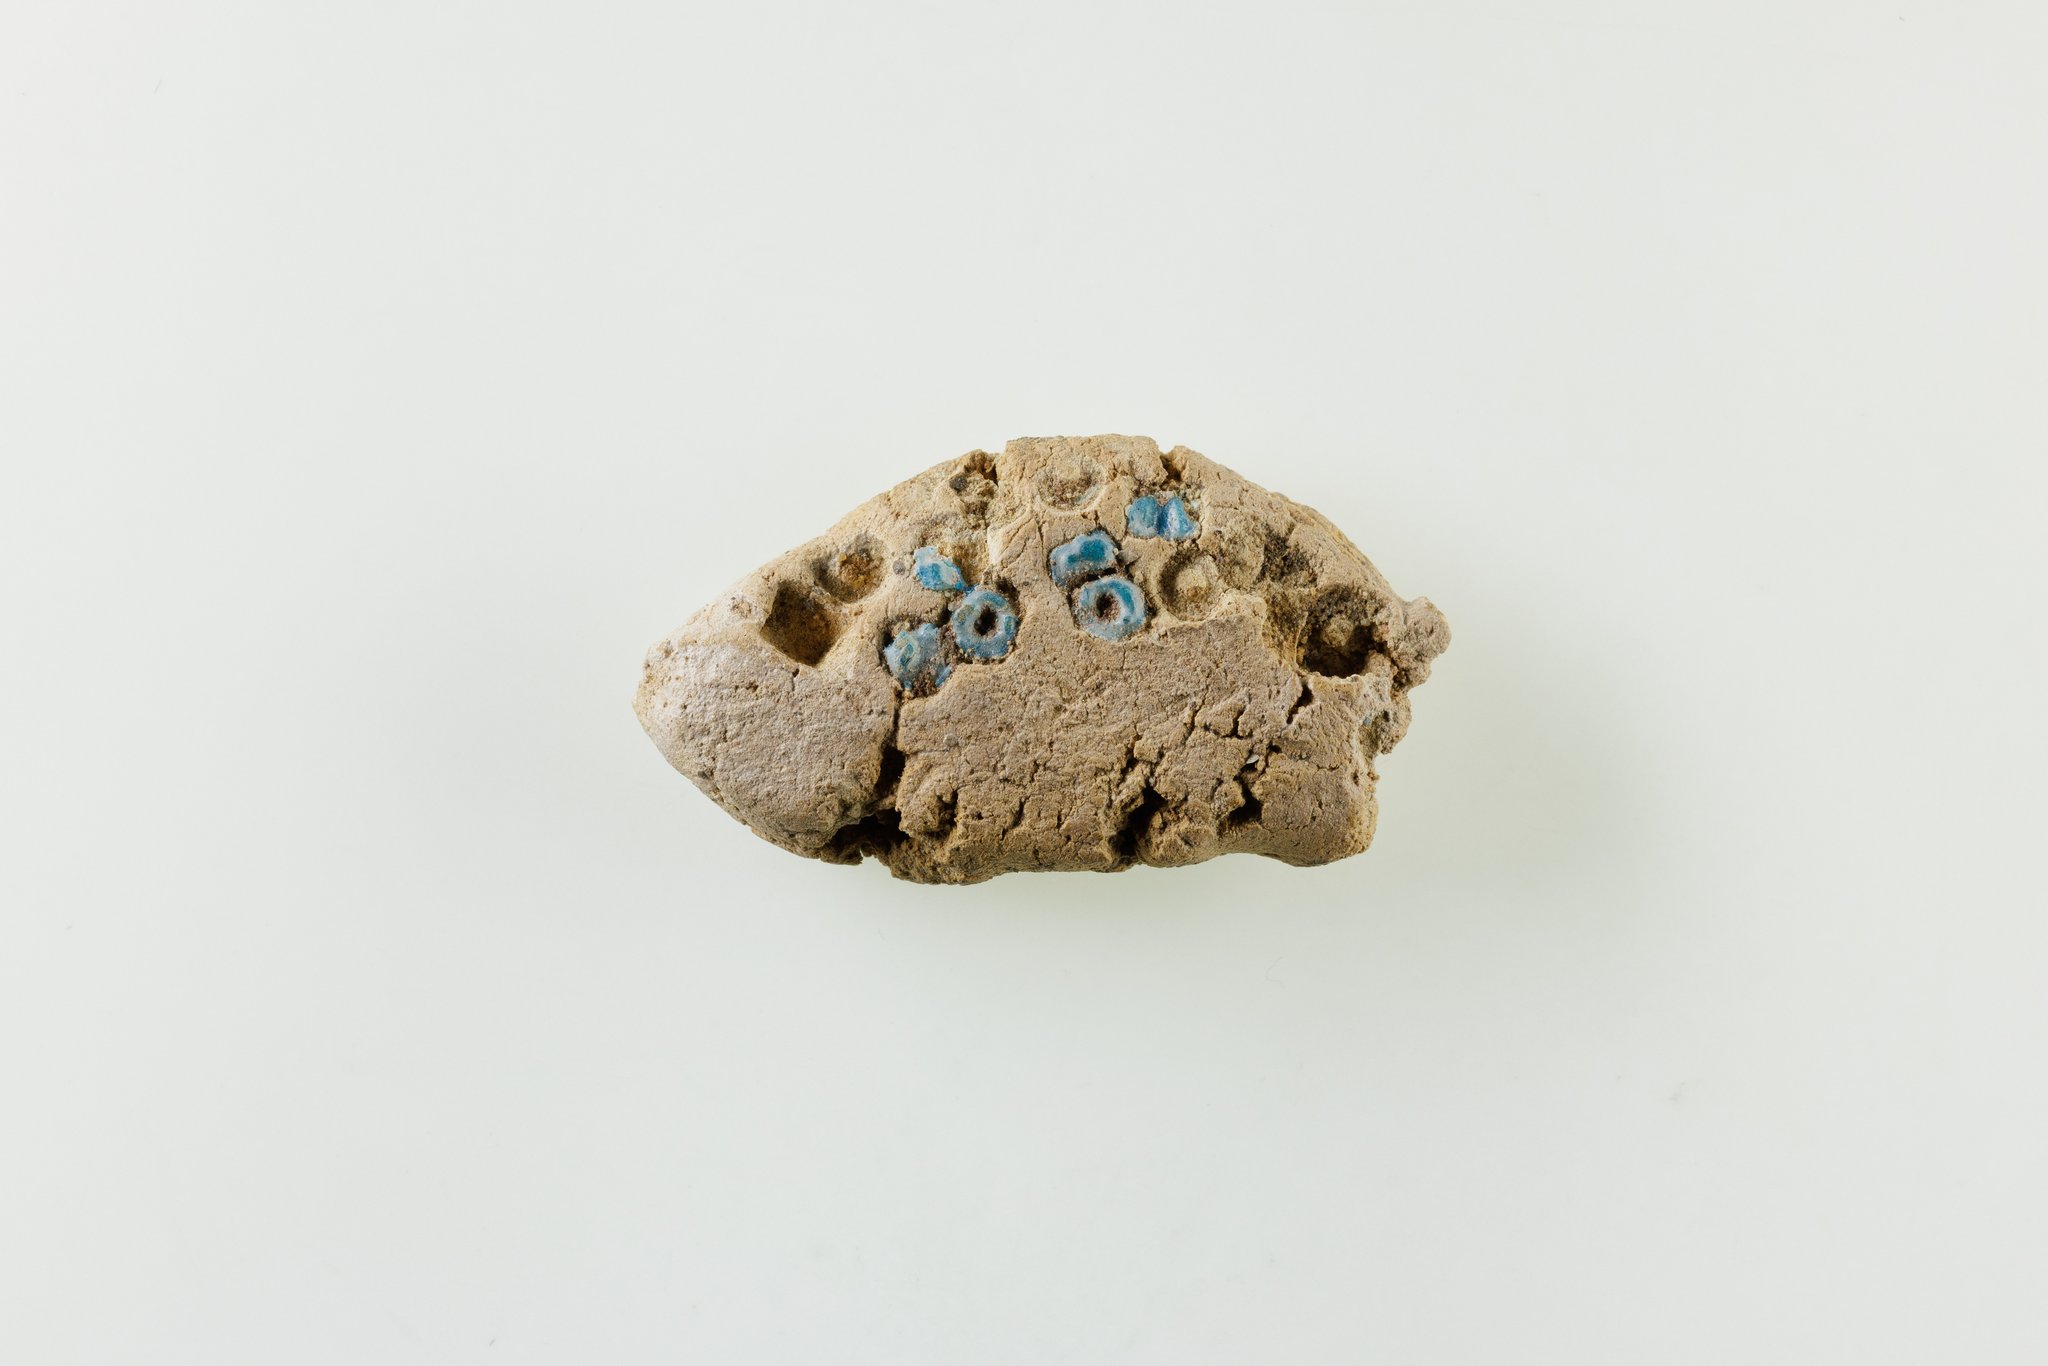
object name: fragment, clay, ring bead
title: Fragment of clay lump with imbedded ring beads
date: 1802-1450 BCE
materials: clay, faience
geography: egypt